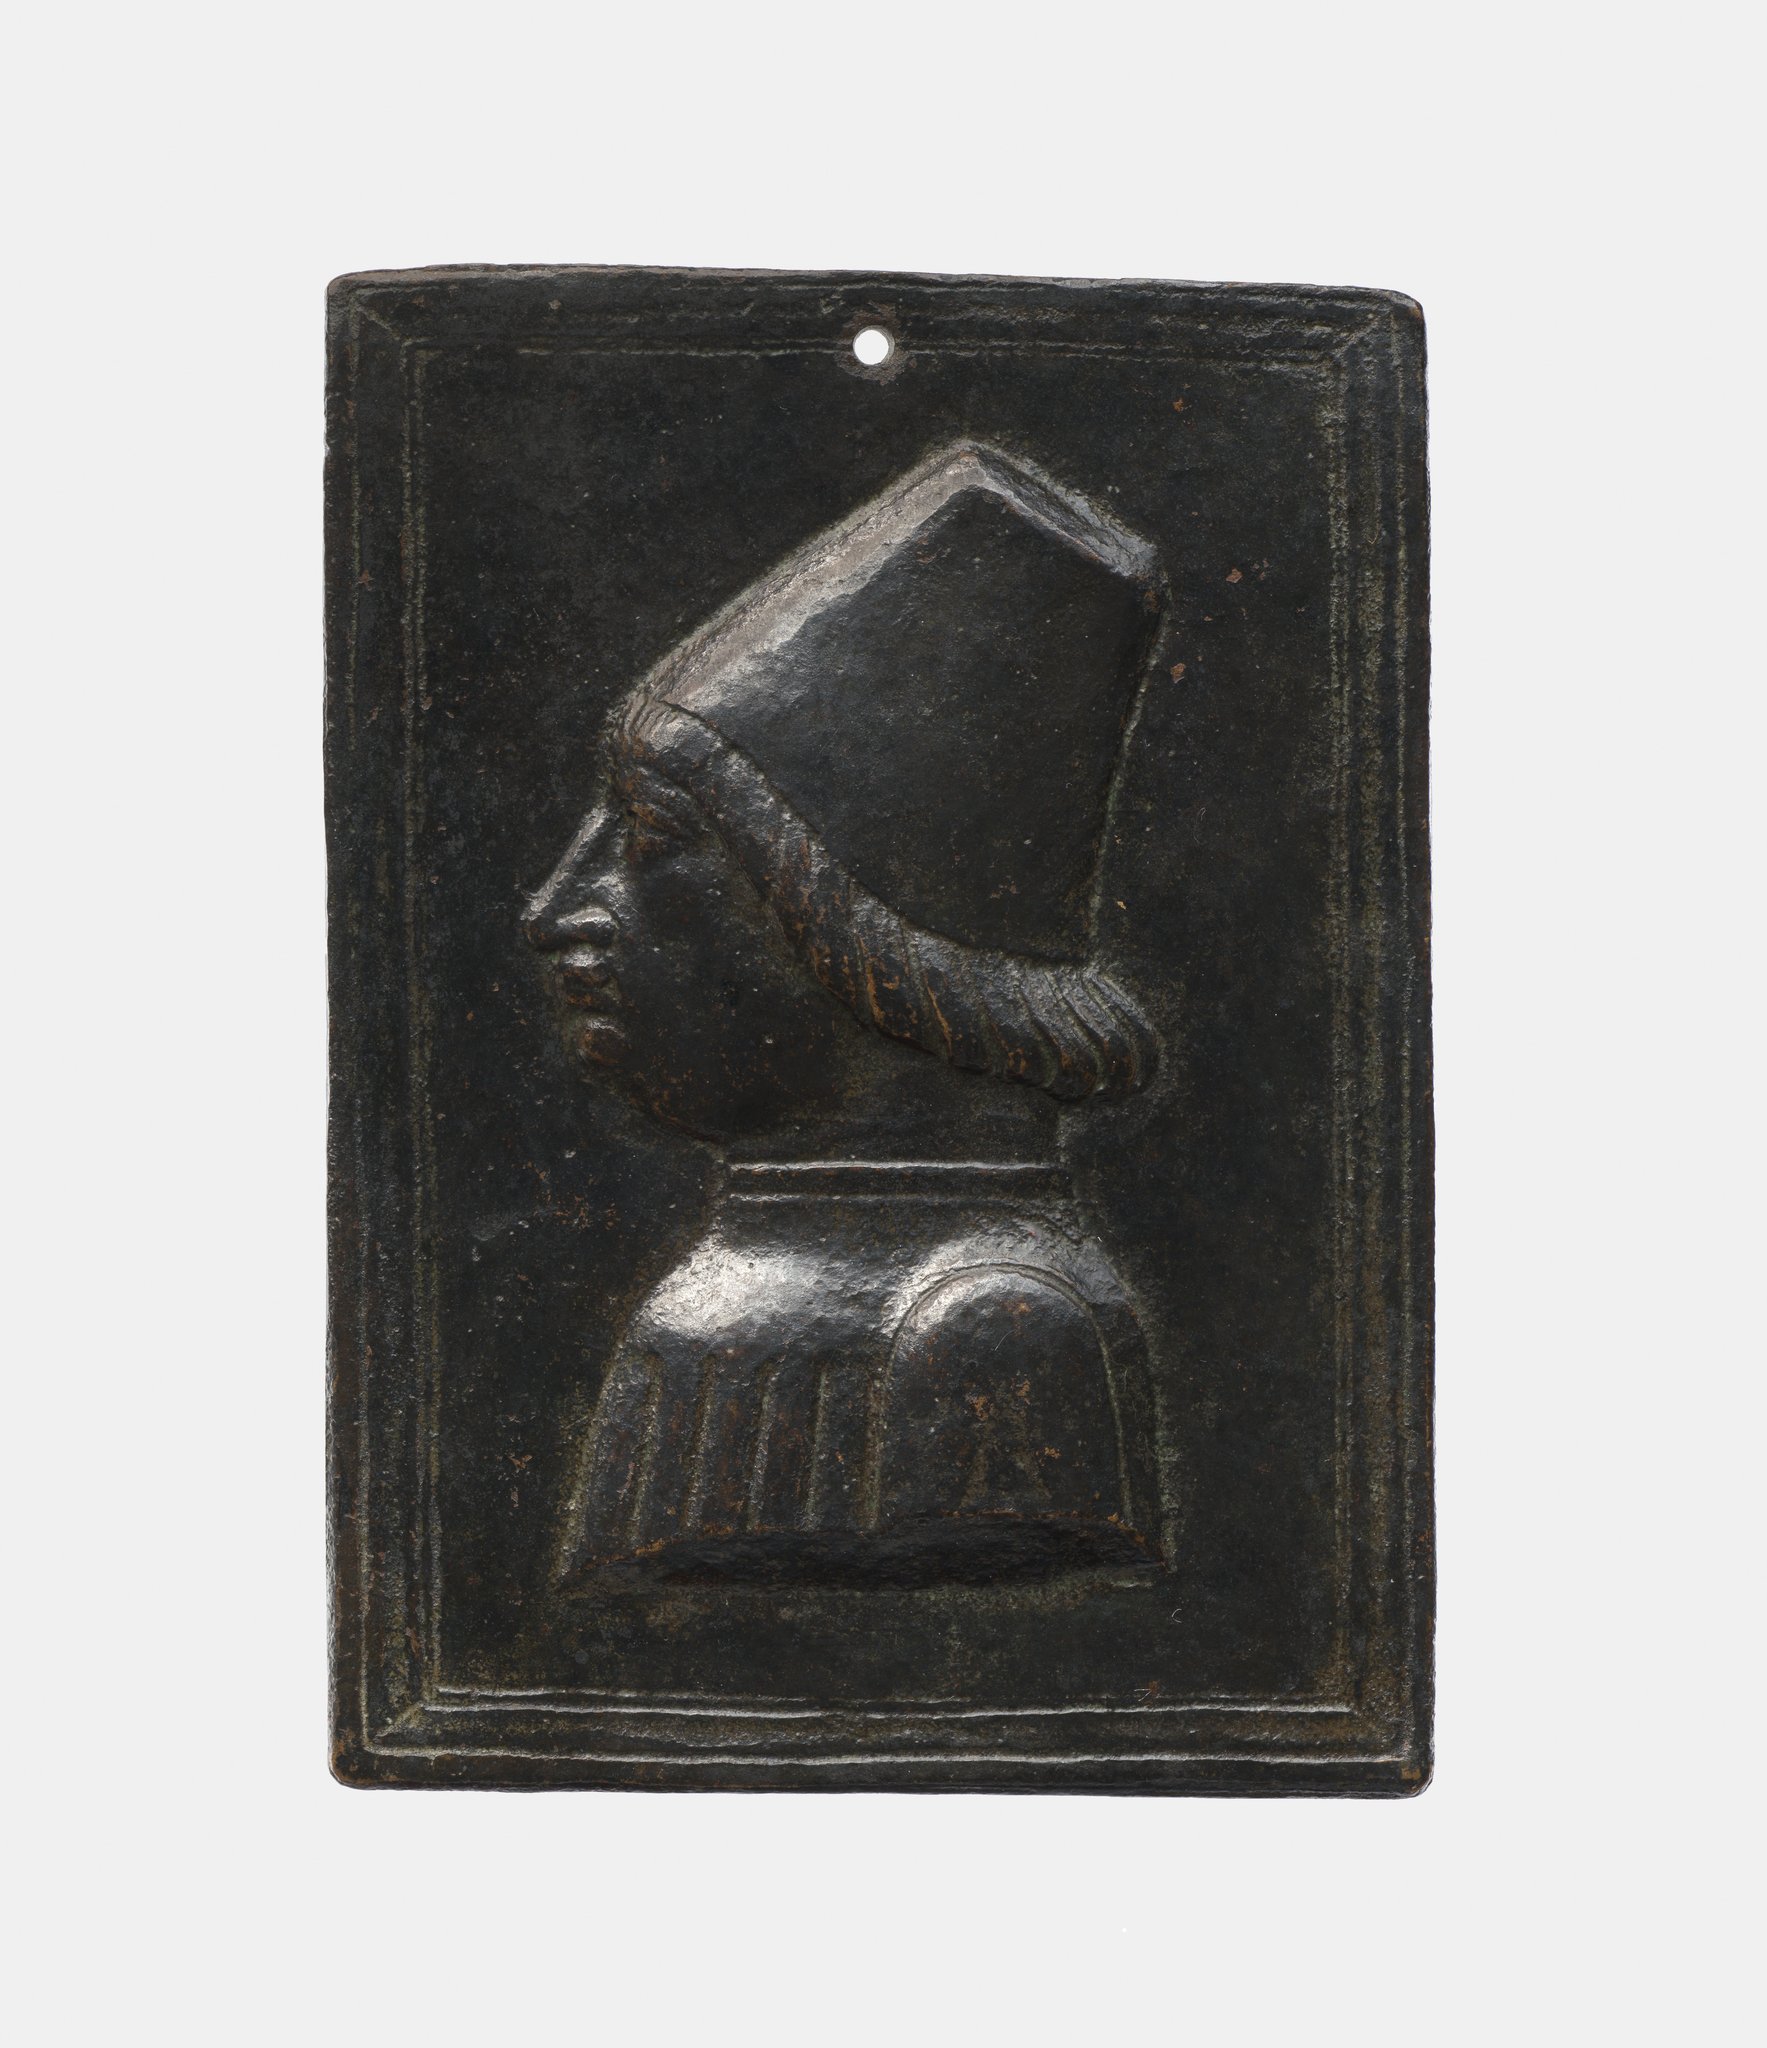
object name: medal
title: Unknown Man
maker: Anonymous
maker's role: artist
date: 1470-1500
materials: bronze